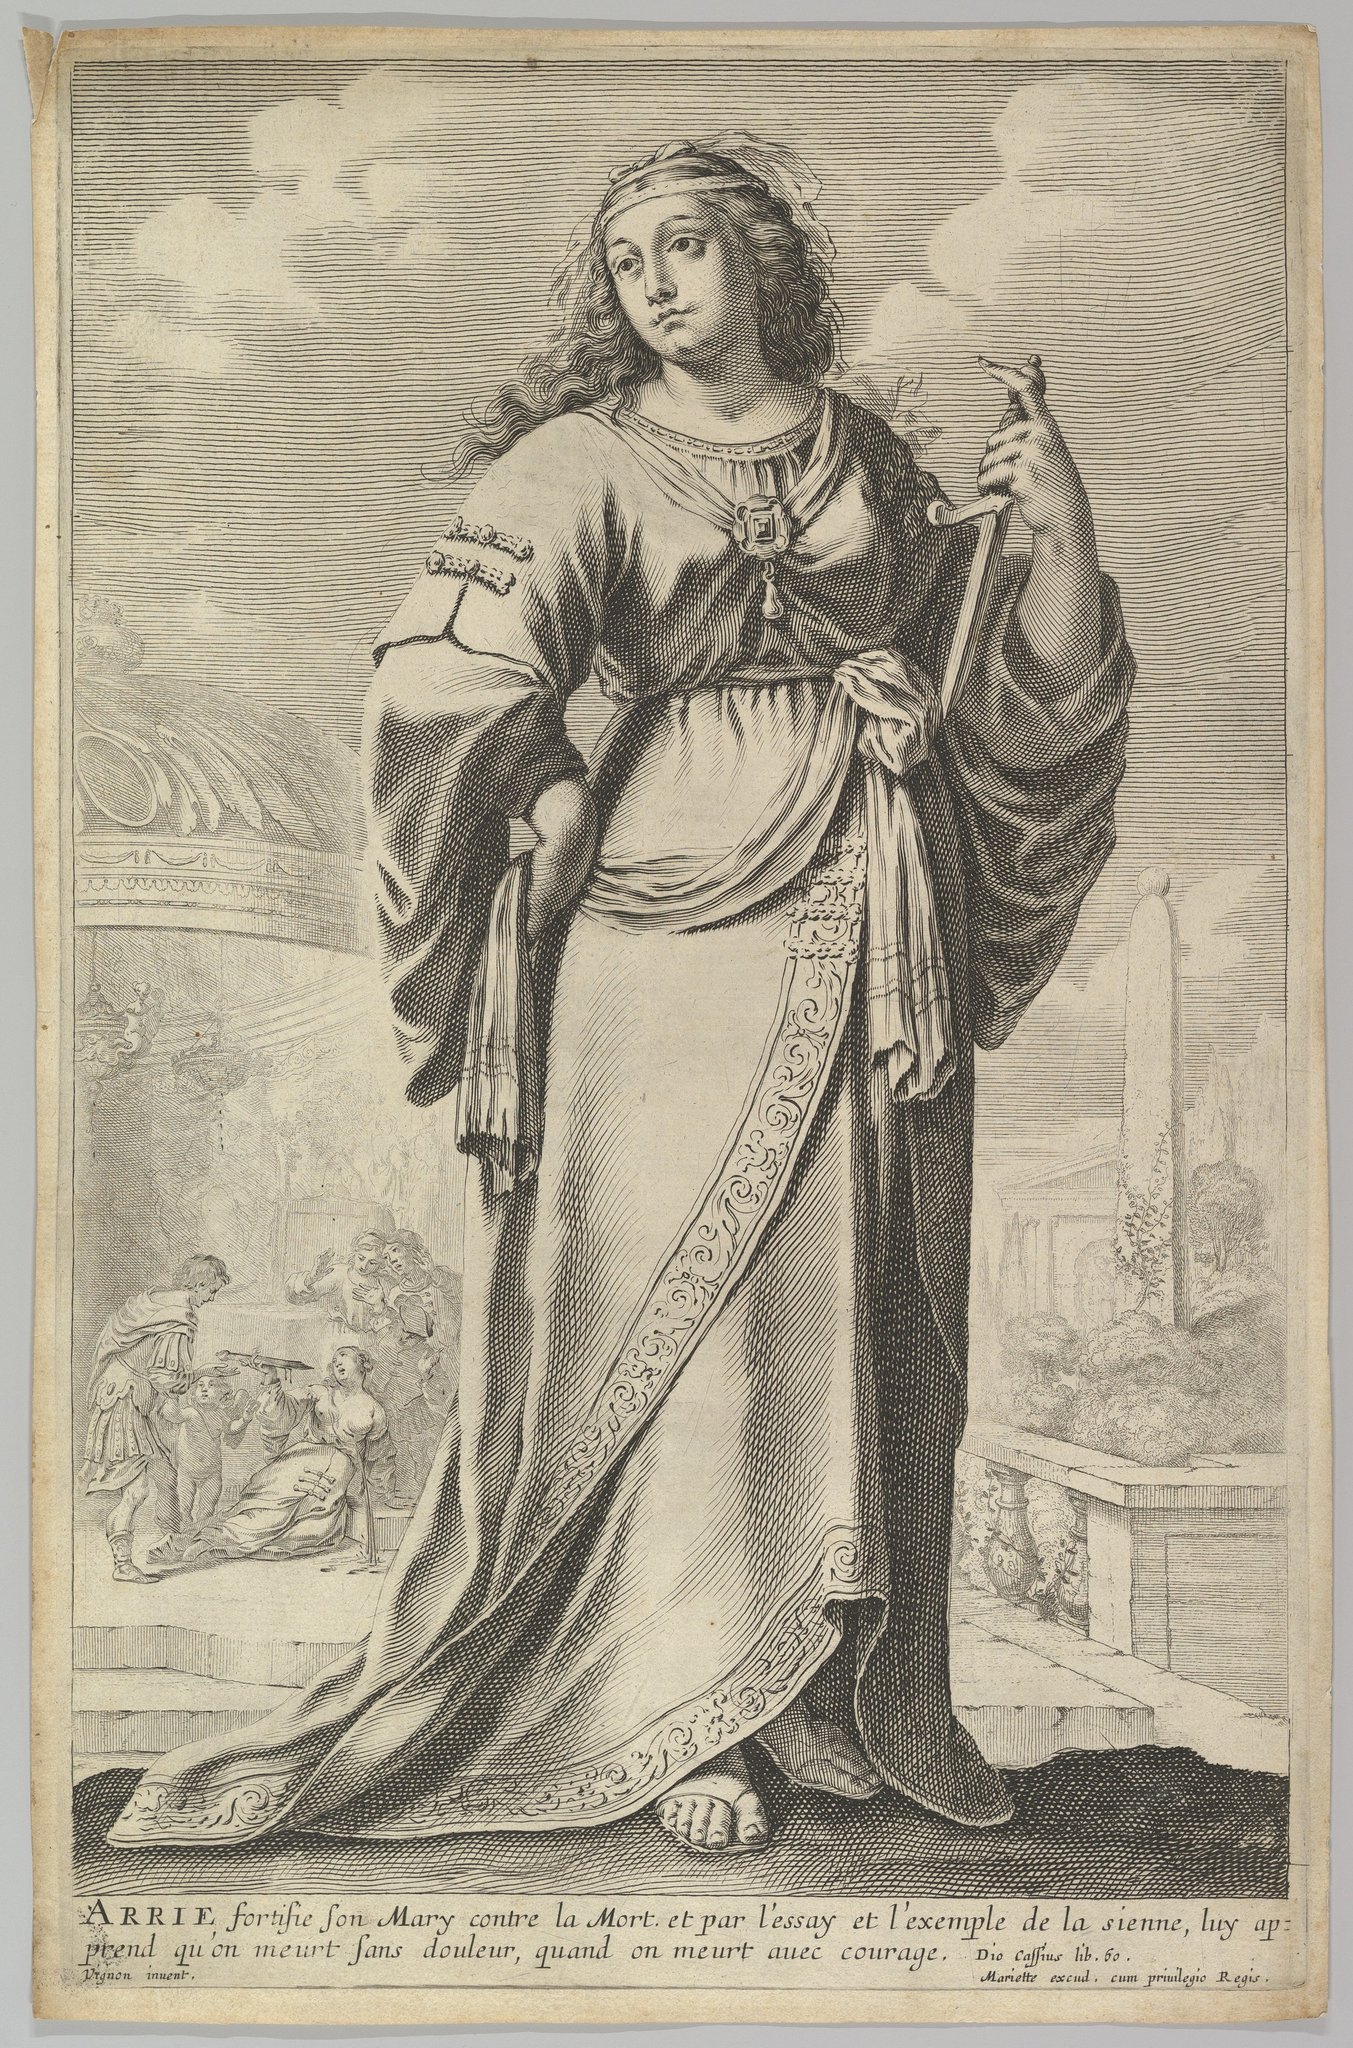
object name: print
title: Arrie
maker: gilles rousselet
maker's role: artist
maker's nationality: french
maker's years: 1614-1686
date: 1647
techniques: engraving, etching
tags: knives,women